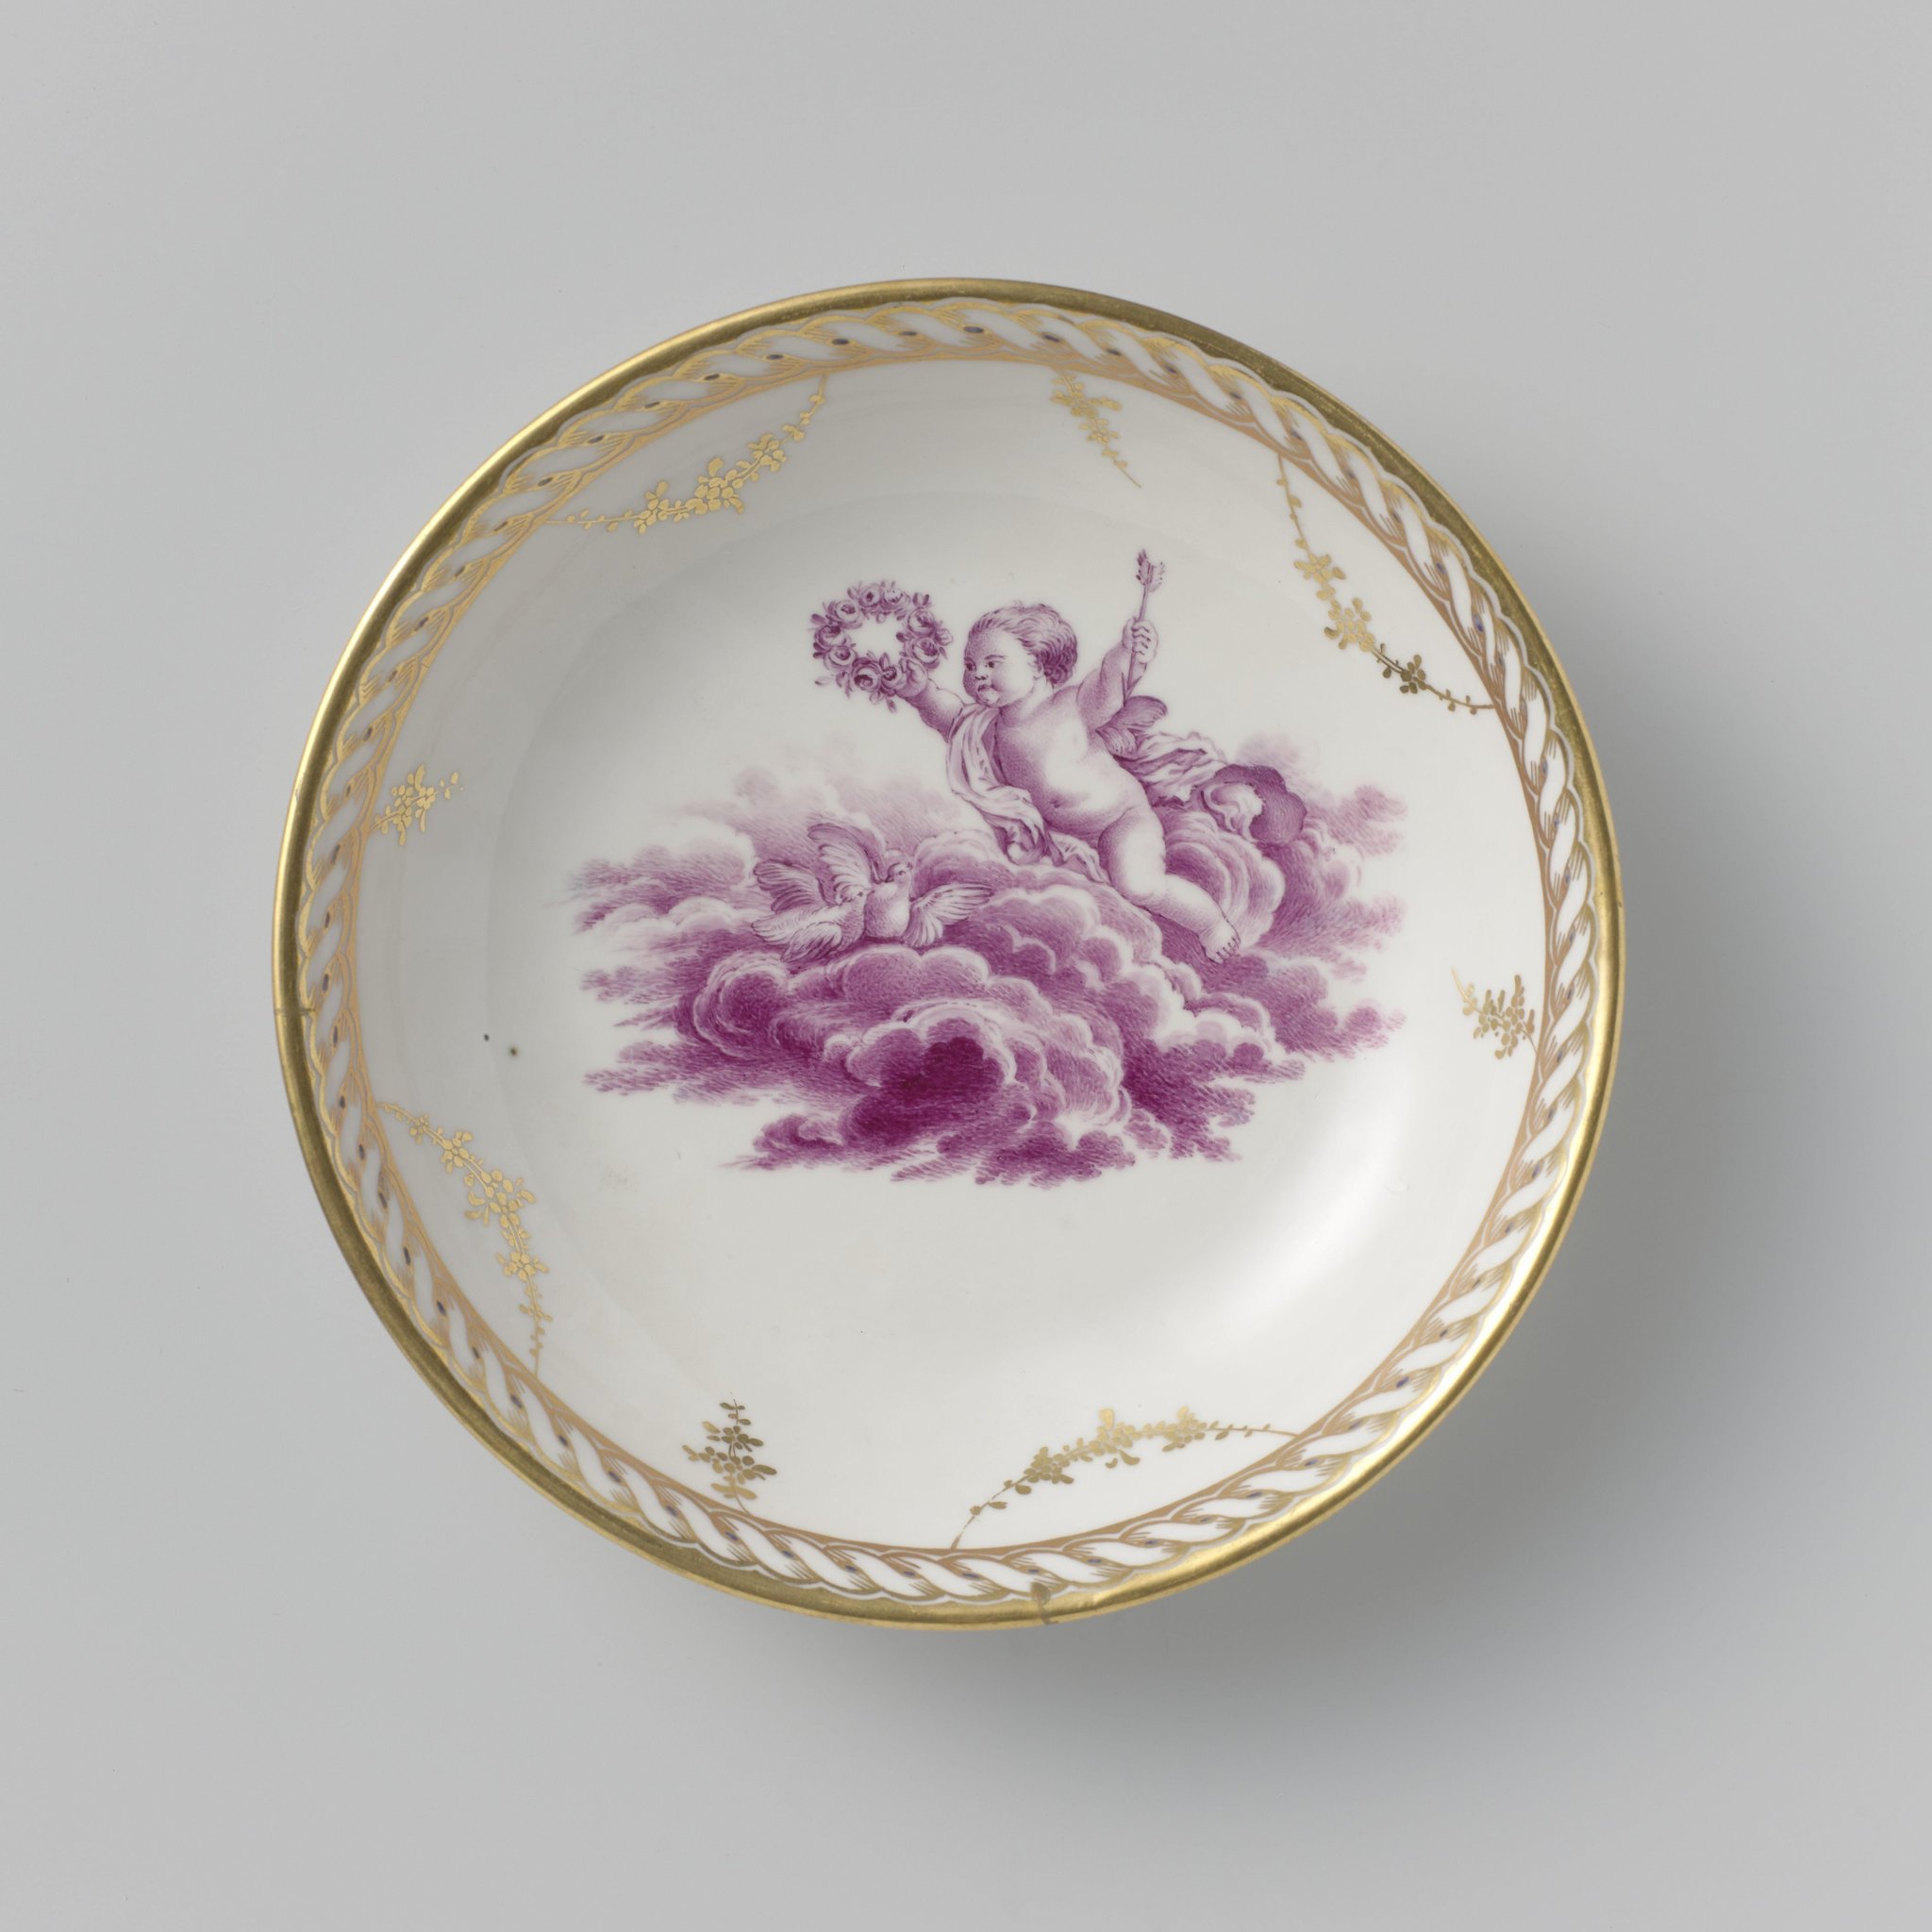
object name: service set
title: Saucer with a putto on clouds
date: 1785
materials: glaze, gold, paint, porcelain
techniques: firing, forming, gilding, turning, vitrification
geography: germany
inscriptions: mark: ‘ooievaar’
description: Schotel van porselein, beschilderd op het glazuur in roze (camaïeu) en goud. Op het plat een putto met een pijl en een krans in zijn handen op een wolk. Voor hem twee vogels. De binnenrand met een gedraaide band, waaraan guirlandes en bloemtakken hangen. Gouden rand. Gemerkt op de onderzijde met de ooievaar.